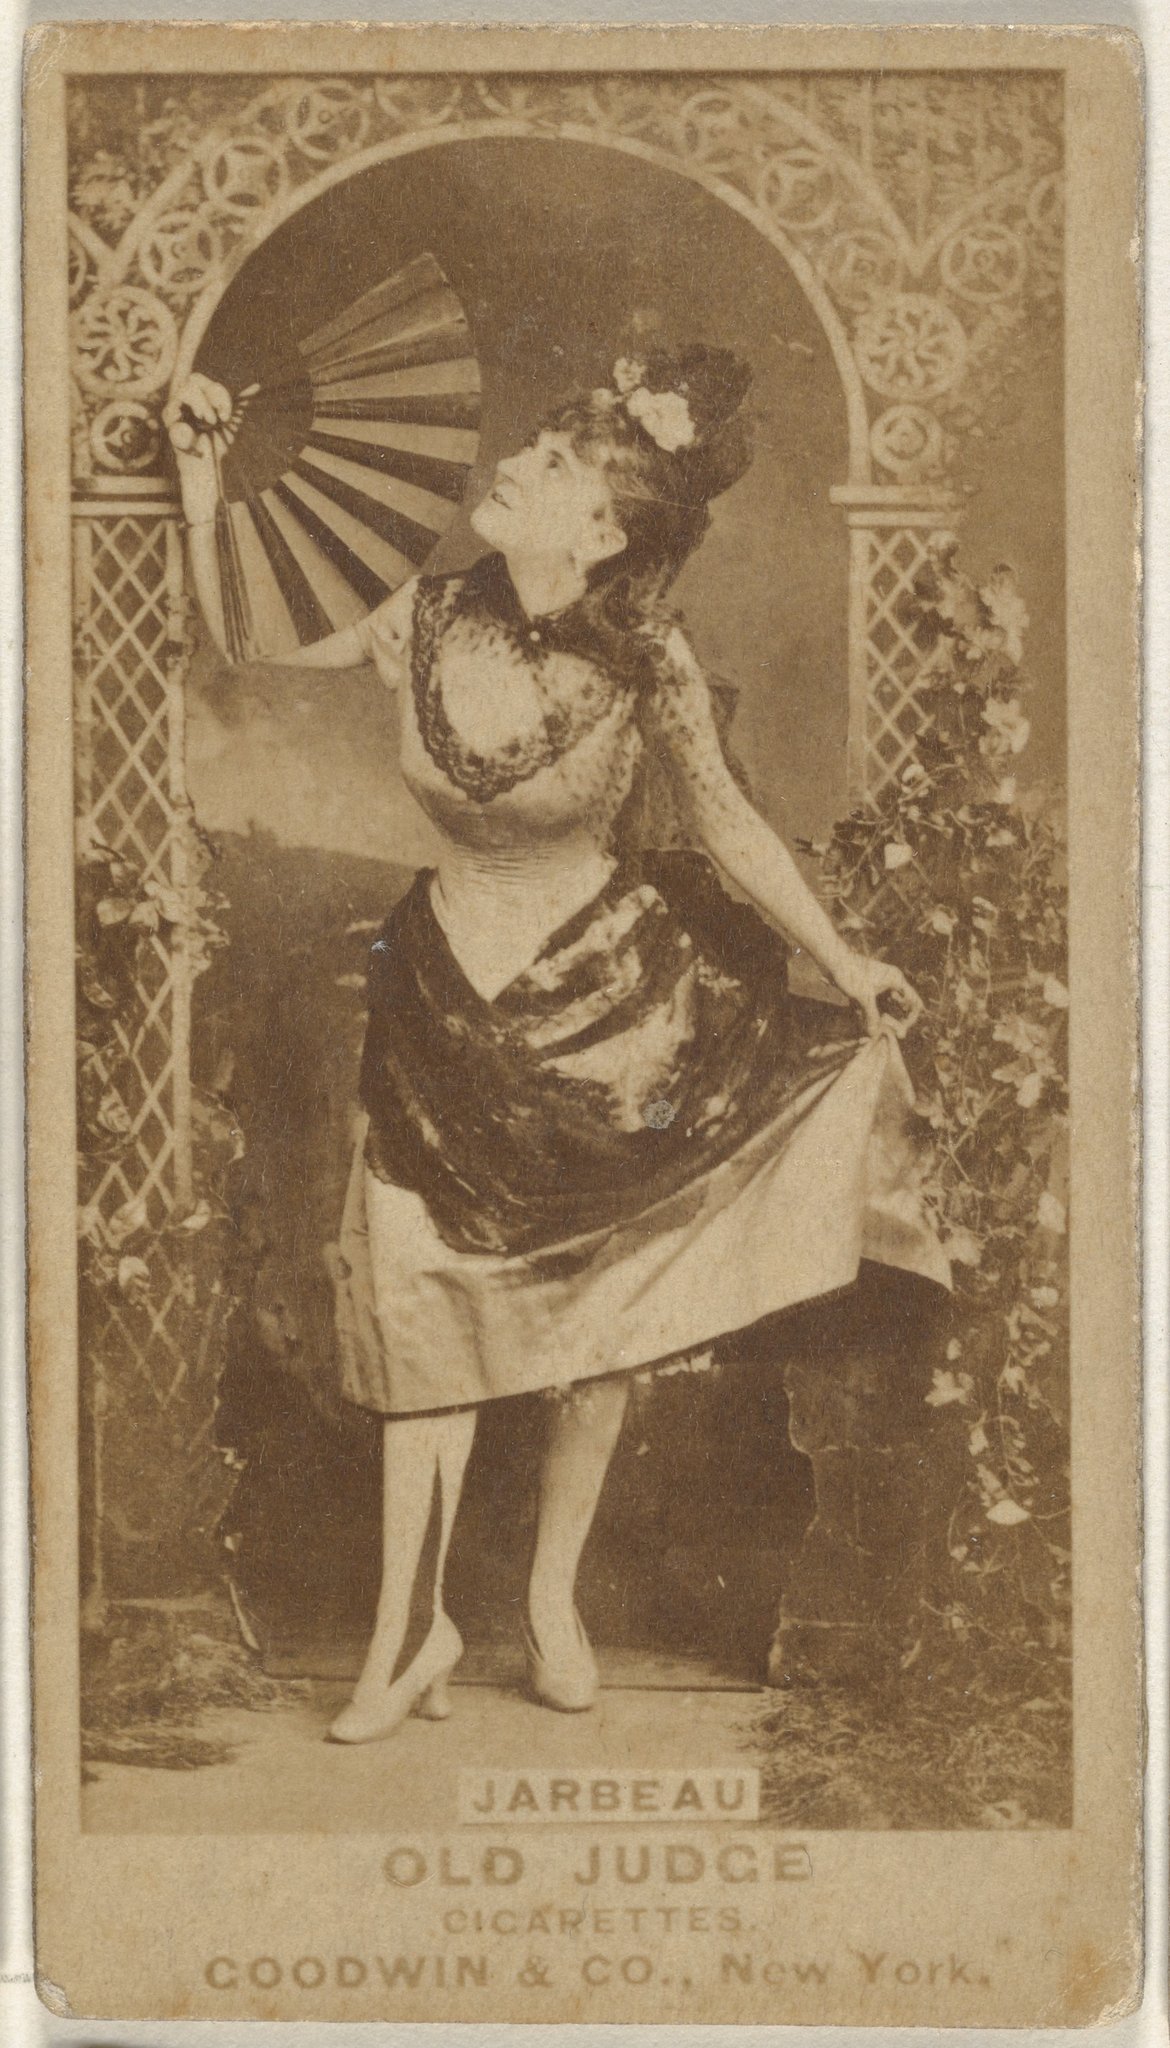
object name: photograph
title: (Vernona) Jarbeau, from the Actors and Actresses series (N171) for Old Judge Cigarettes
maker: goodwin & company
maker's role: publisher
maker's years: 1850-1950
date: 1886-1890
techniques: albumen silver print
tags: fans,portraits,women